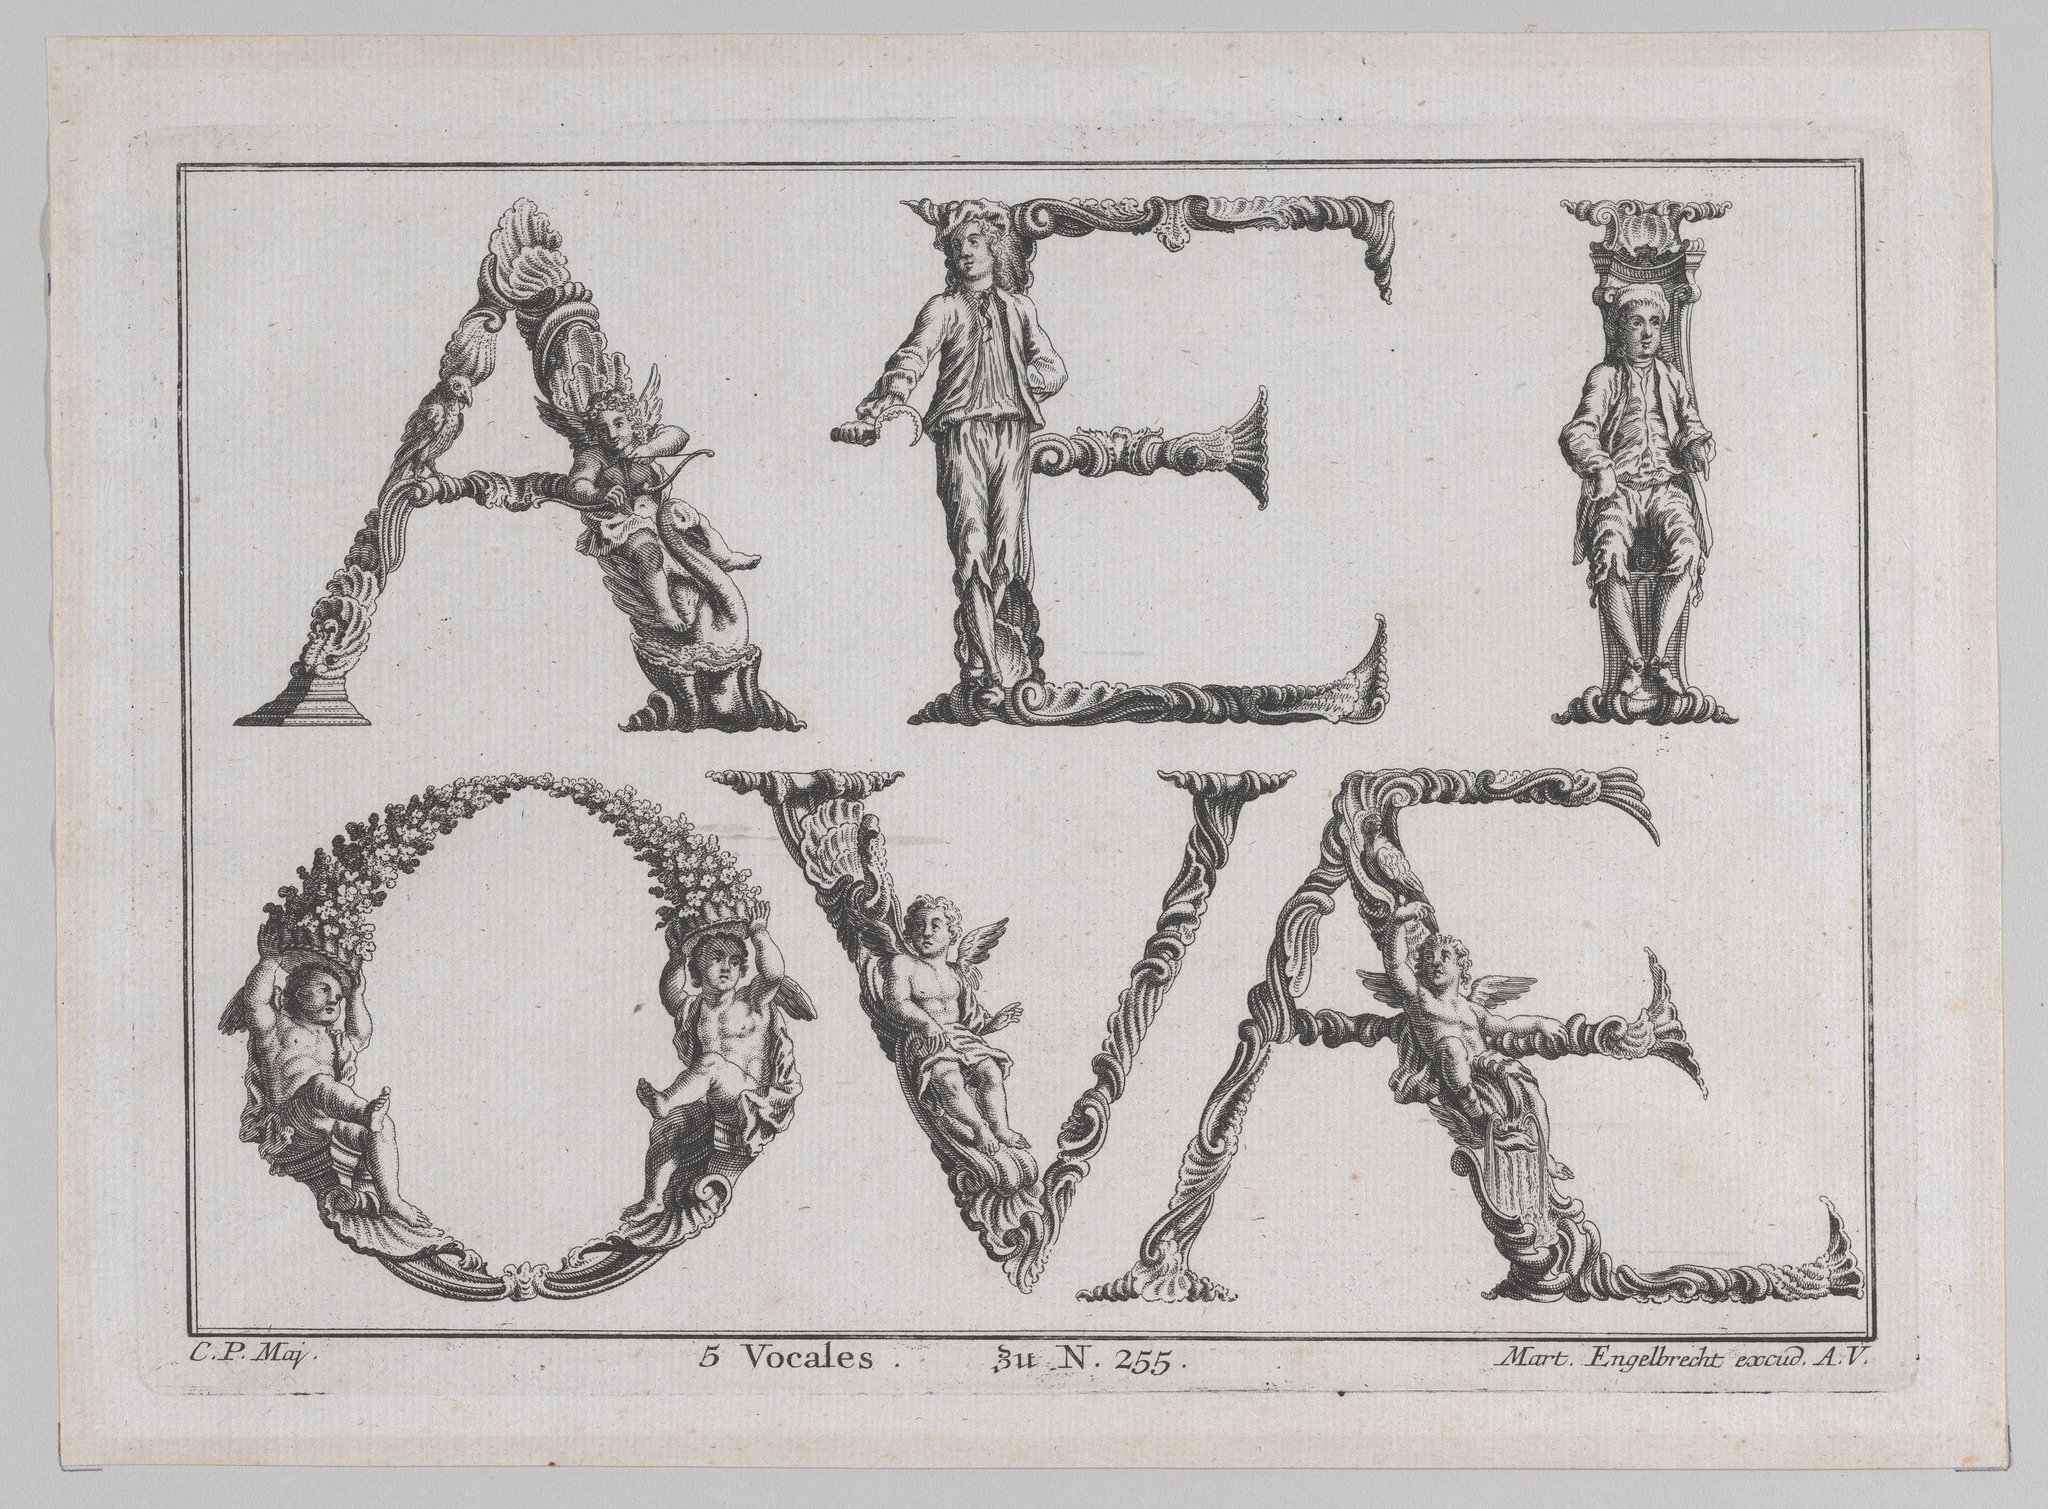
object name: print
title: Alphabet Letters (5 Vowels)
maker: martin engelbrecht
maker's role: artist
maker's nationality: german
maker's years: 1684-1756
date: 1701-1800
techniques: engraving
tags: men